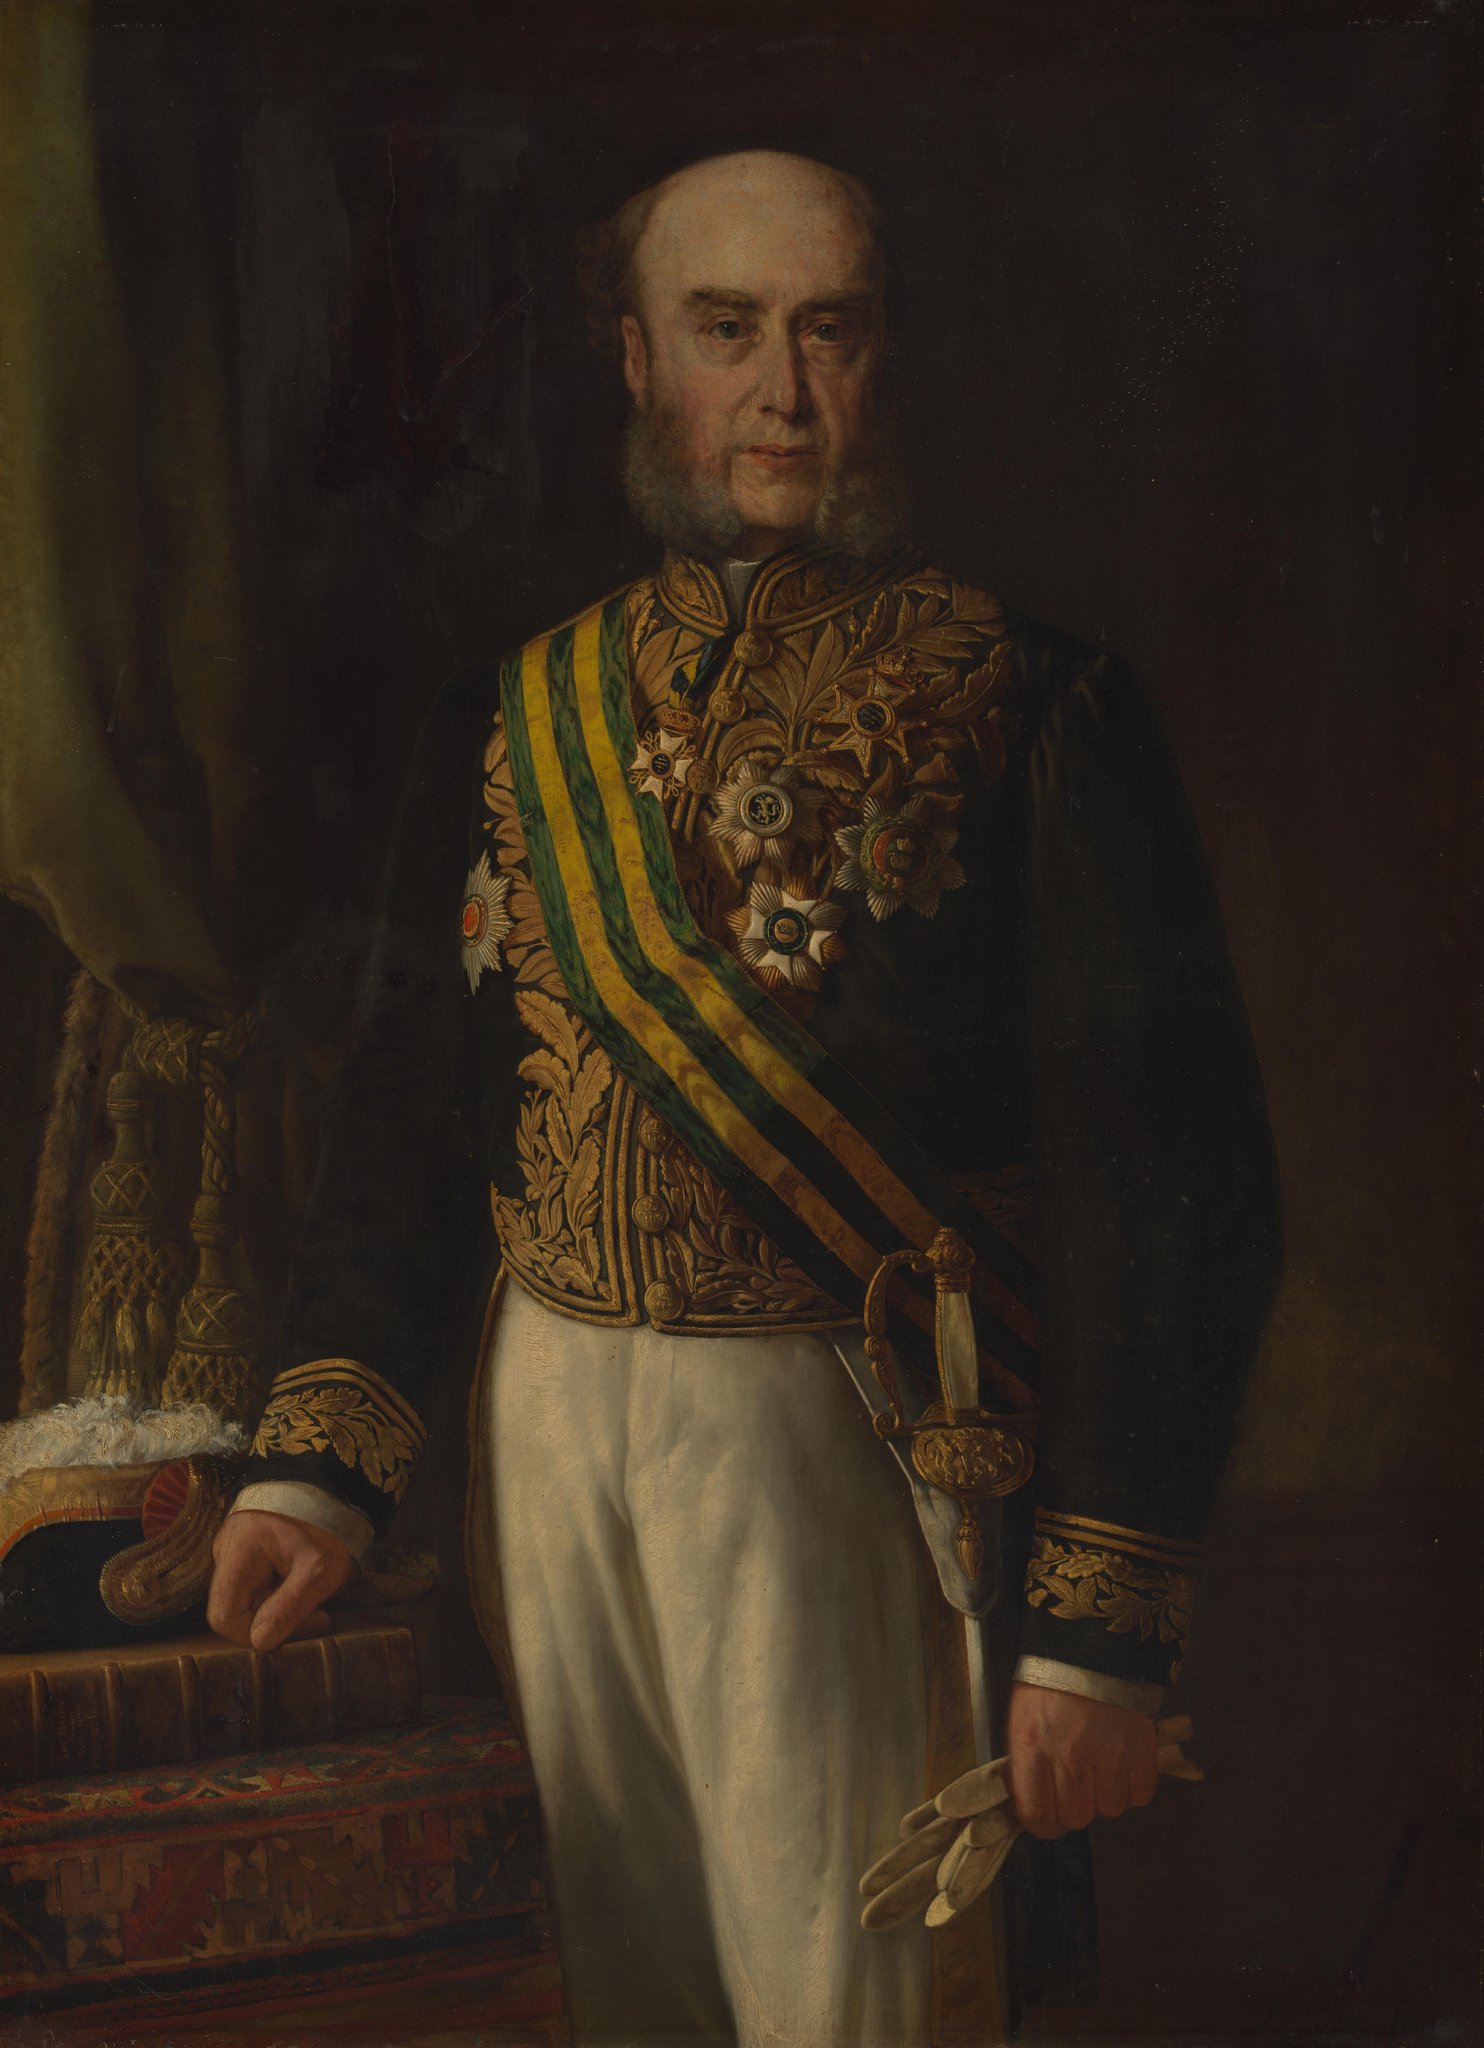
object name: painting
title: James Loudon (1824-1900). Gouverneur-generaal (1871-75)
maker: andries van den berg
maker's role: draughtsman, painter, print maker, publisher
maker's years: 1852-1944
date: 1871-1885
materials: canvas, oil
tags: colonial governor, historical persons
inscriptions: signature: ‘A. v.d. Berg fecit’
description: Portret van James Loudon (1824-1900). Gouverneur-generaal (1871-75). Kniestuk, staande naar links, het gelaat en face. De steek en rechterhand op een boek (Du Bois, Vie des Gouverneurs Generaux), links op een tafel. In de linkerhand een paar handschoenen. Onderdeel van een reeks van portretten van de gouverneurs-generaal van het voormalige Nederlands Oost-Indië.